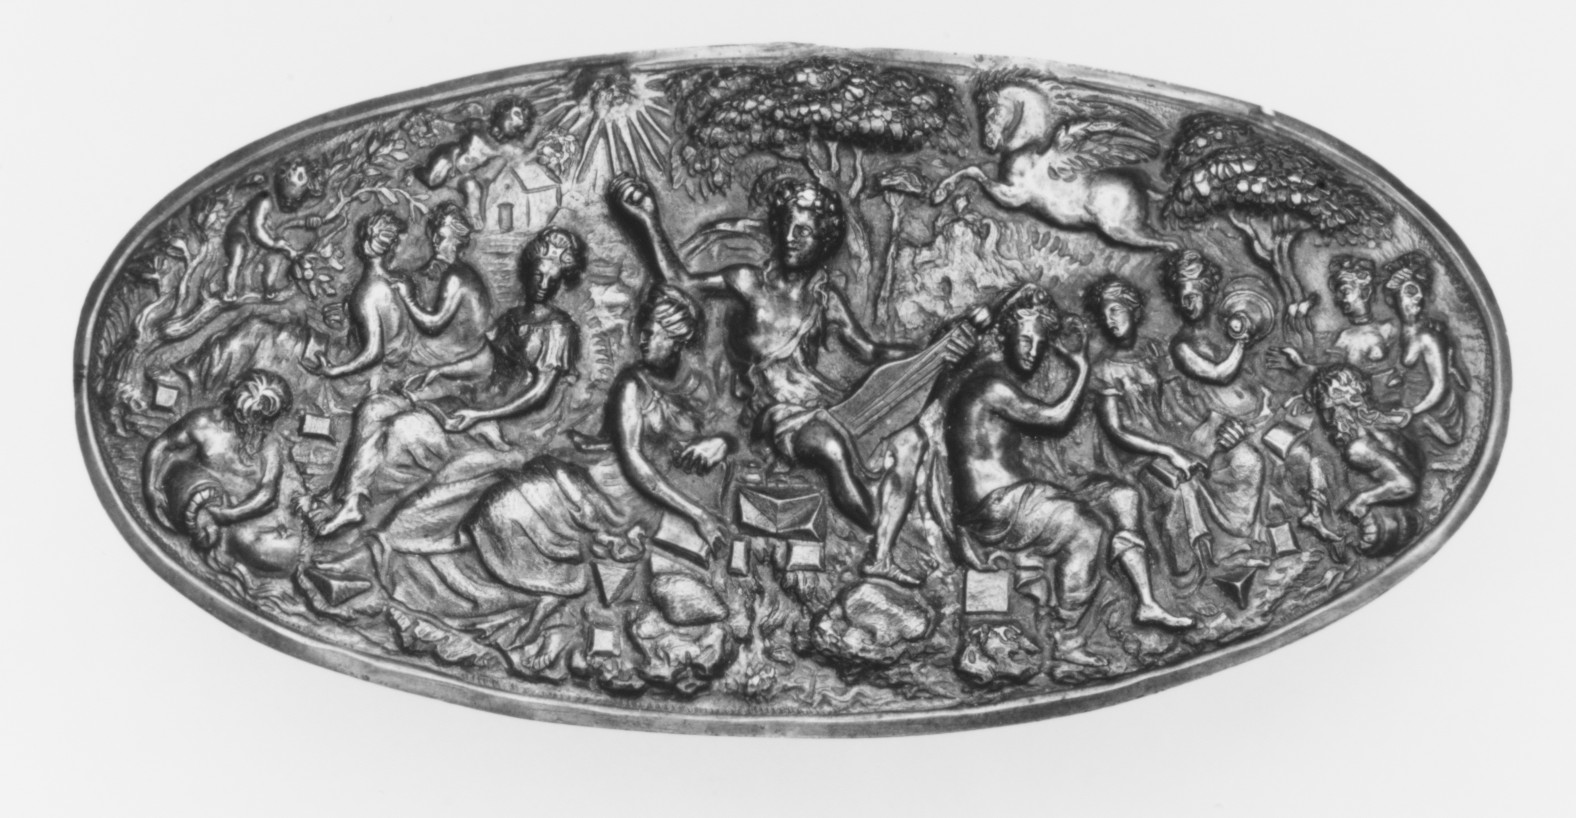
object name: plaquette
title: Parnassus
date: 1560-1565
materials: bronze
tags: men,women